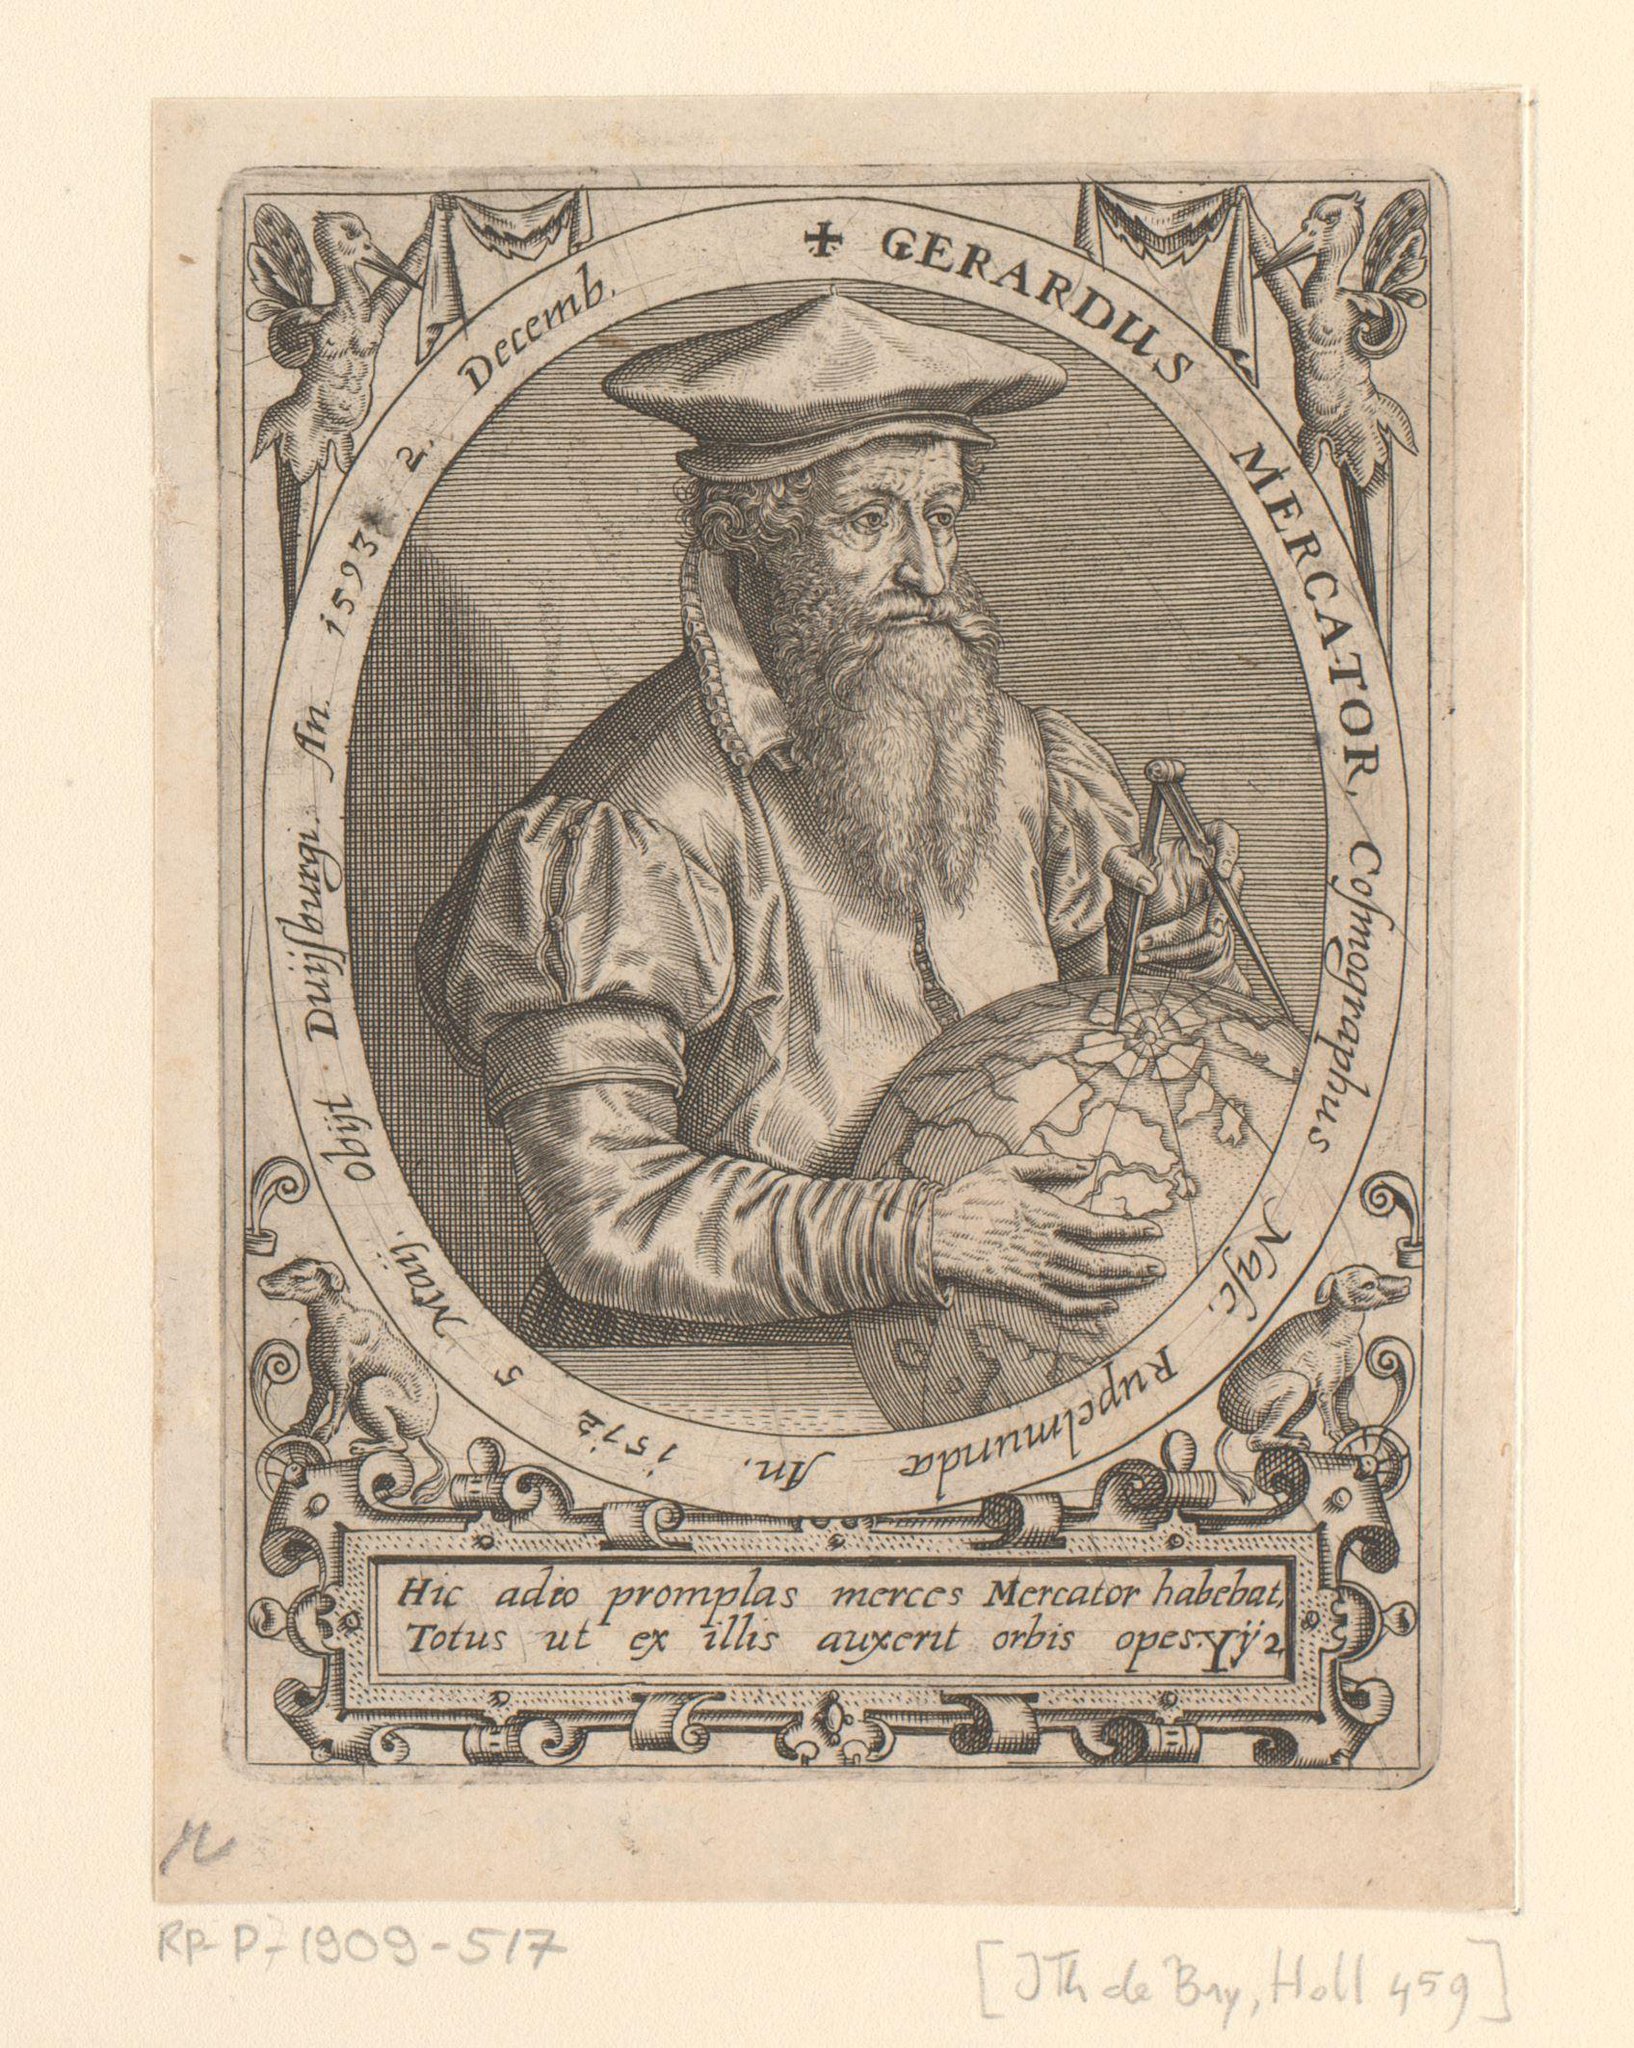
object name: book illustration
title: Portret van Gerard Mercator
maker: jean jacques boissard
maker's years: 1528-1598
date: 1669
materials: paper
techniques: engraving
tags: gerardus mercator, science and technology (+ portrait of scholar, scientist)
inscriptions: collector's mark: Lugt 2228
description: Gemaakt voor: J.J. Boissard, Icones virorum illustrium doctrina &c eruditione praestanti um contines. Frankfurt am Main: de Bry, 1597-1599. Opnieuw gebruikt in: J.J.Boissard, Bibliotheca chalcographica, hoc est Virtute et eruditione clarorum Virorum Imagines. Heidelberg: Clemens Ammon, 1669 (te herkennen aan de toegevoegde signatuur in de rechter onderhoek: 2Y2).